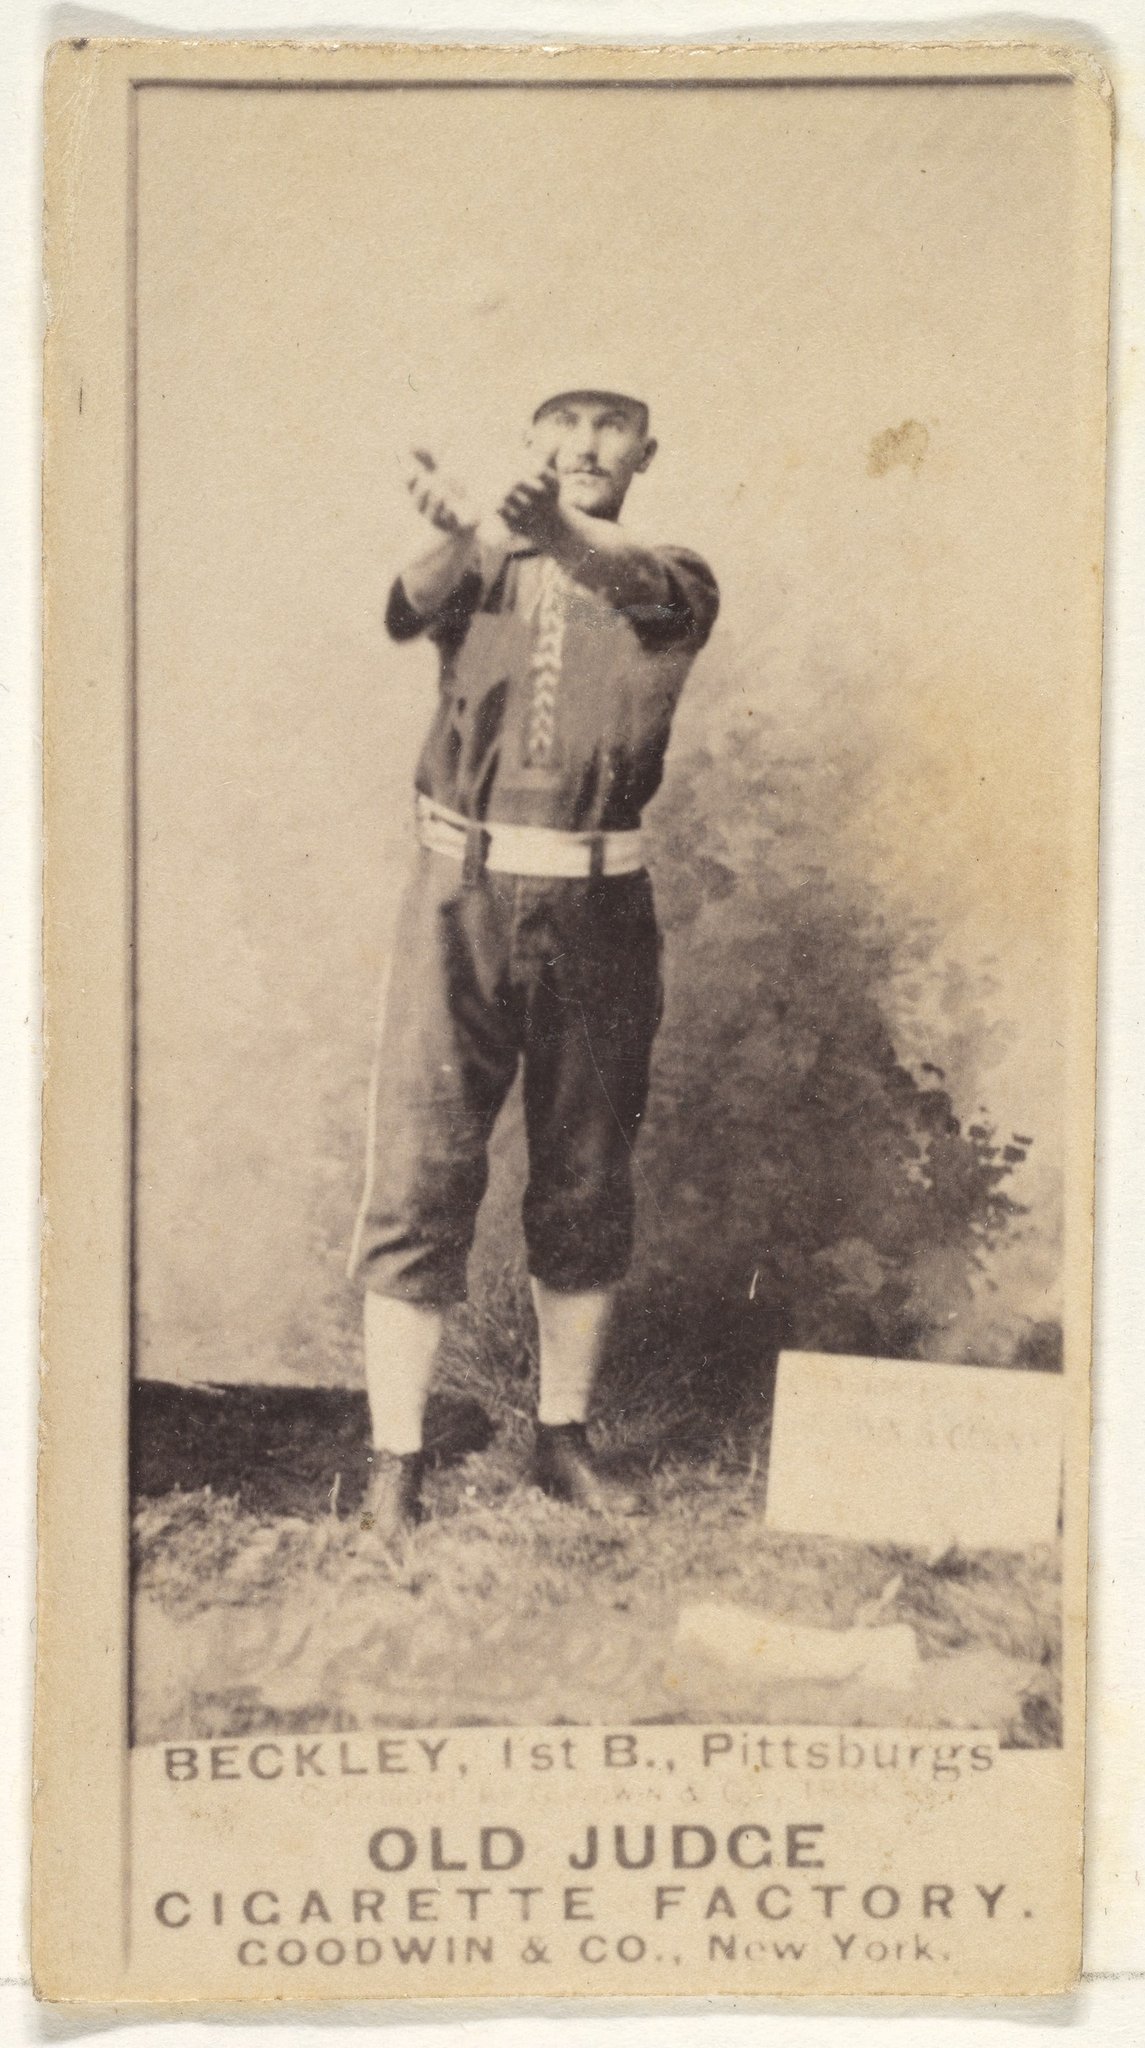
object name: baseball card, photograph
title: Jacob Peter "Eagle Eye" Beckley, 1st Base, Pittsburgh, from the Old Judge series (N172) for Old Judge Cigarettes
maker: goodwin & company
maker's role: publisher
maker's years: 1850-1950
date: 1888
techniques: albumen silver print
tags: men,portraits,baseball,athletes